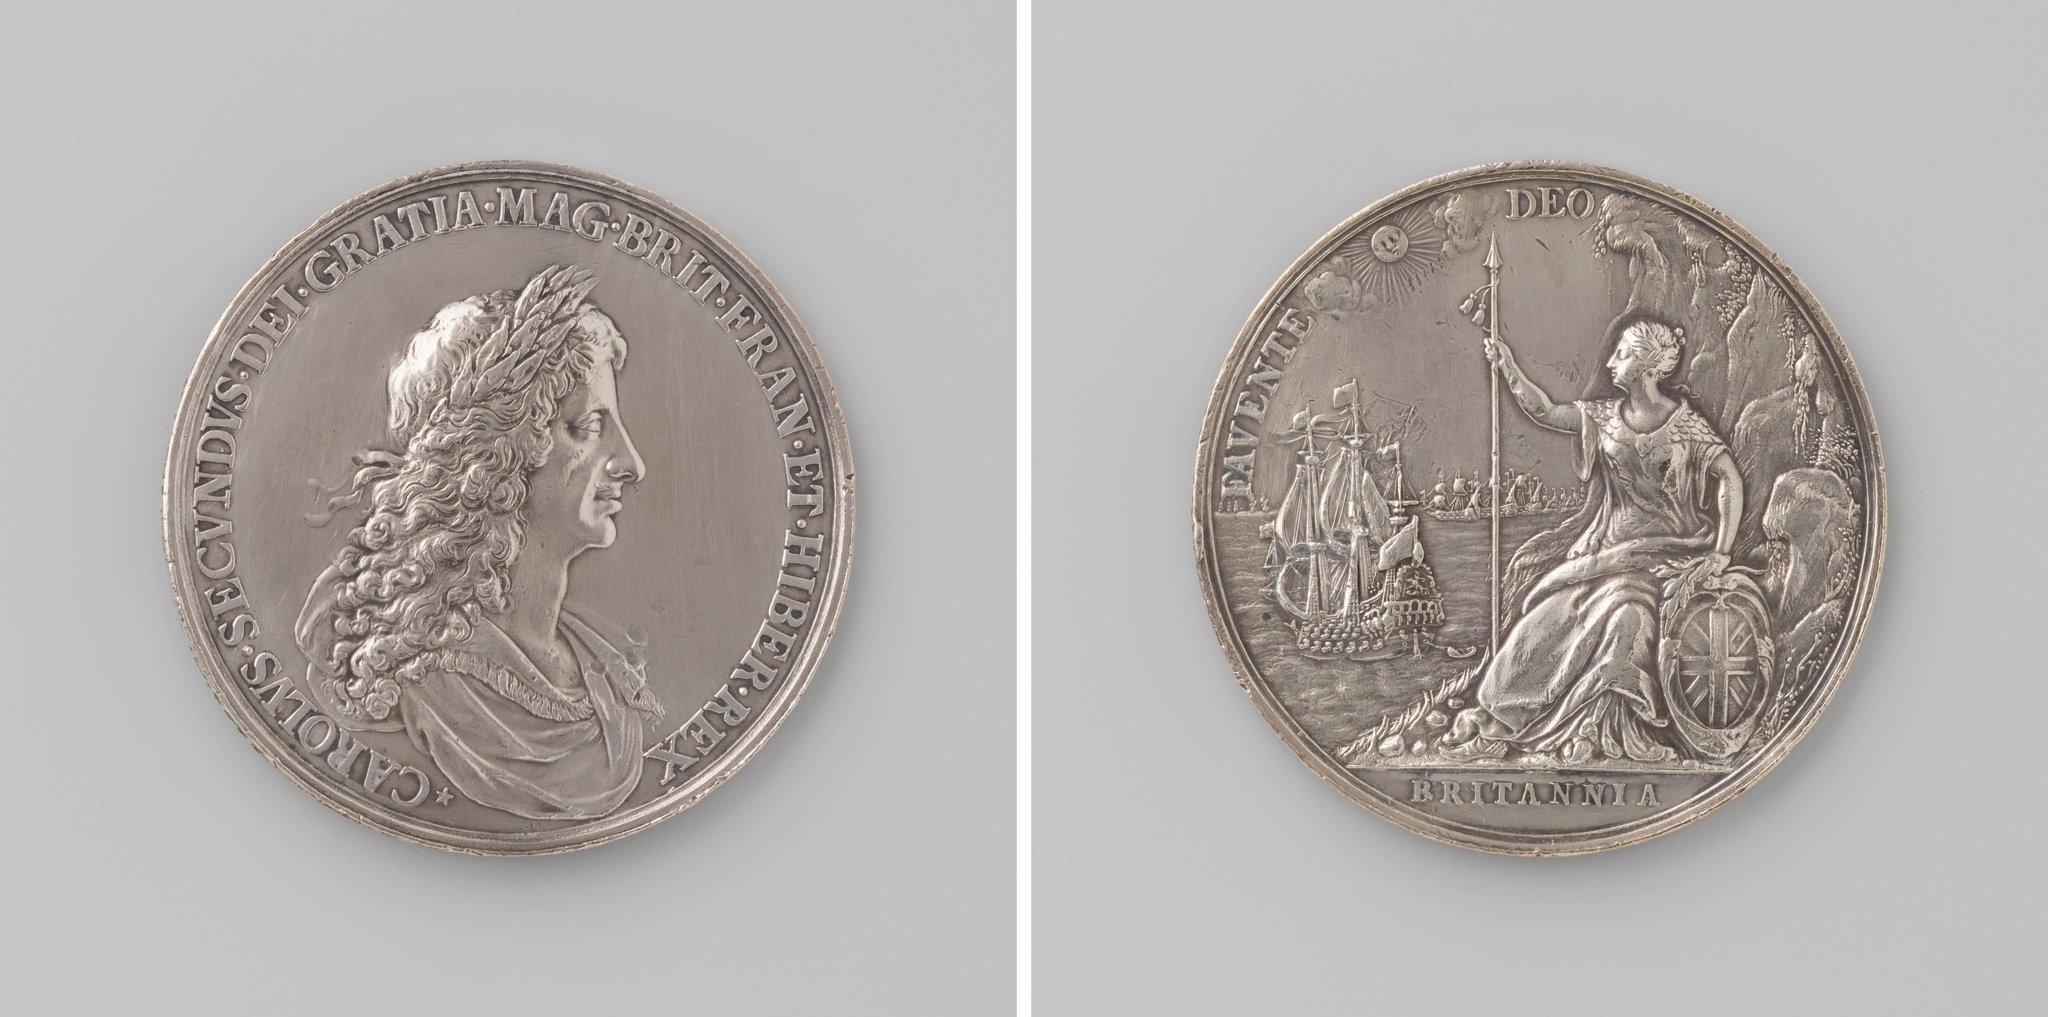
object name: honorary medal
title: Vrede van Breda, ter ere van Karel II, koning van Engeland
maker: jean roëttiers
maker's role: medailleur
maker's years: 1631-1703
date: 1667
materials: silver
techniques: striking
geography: london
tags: karel ii (koning van engeland)